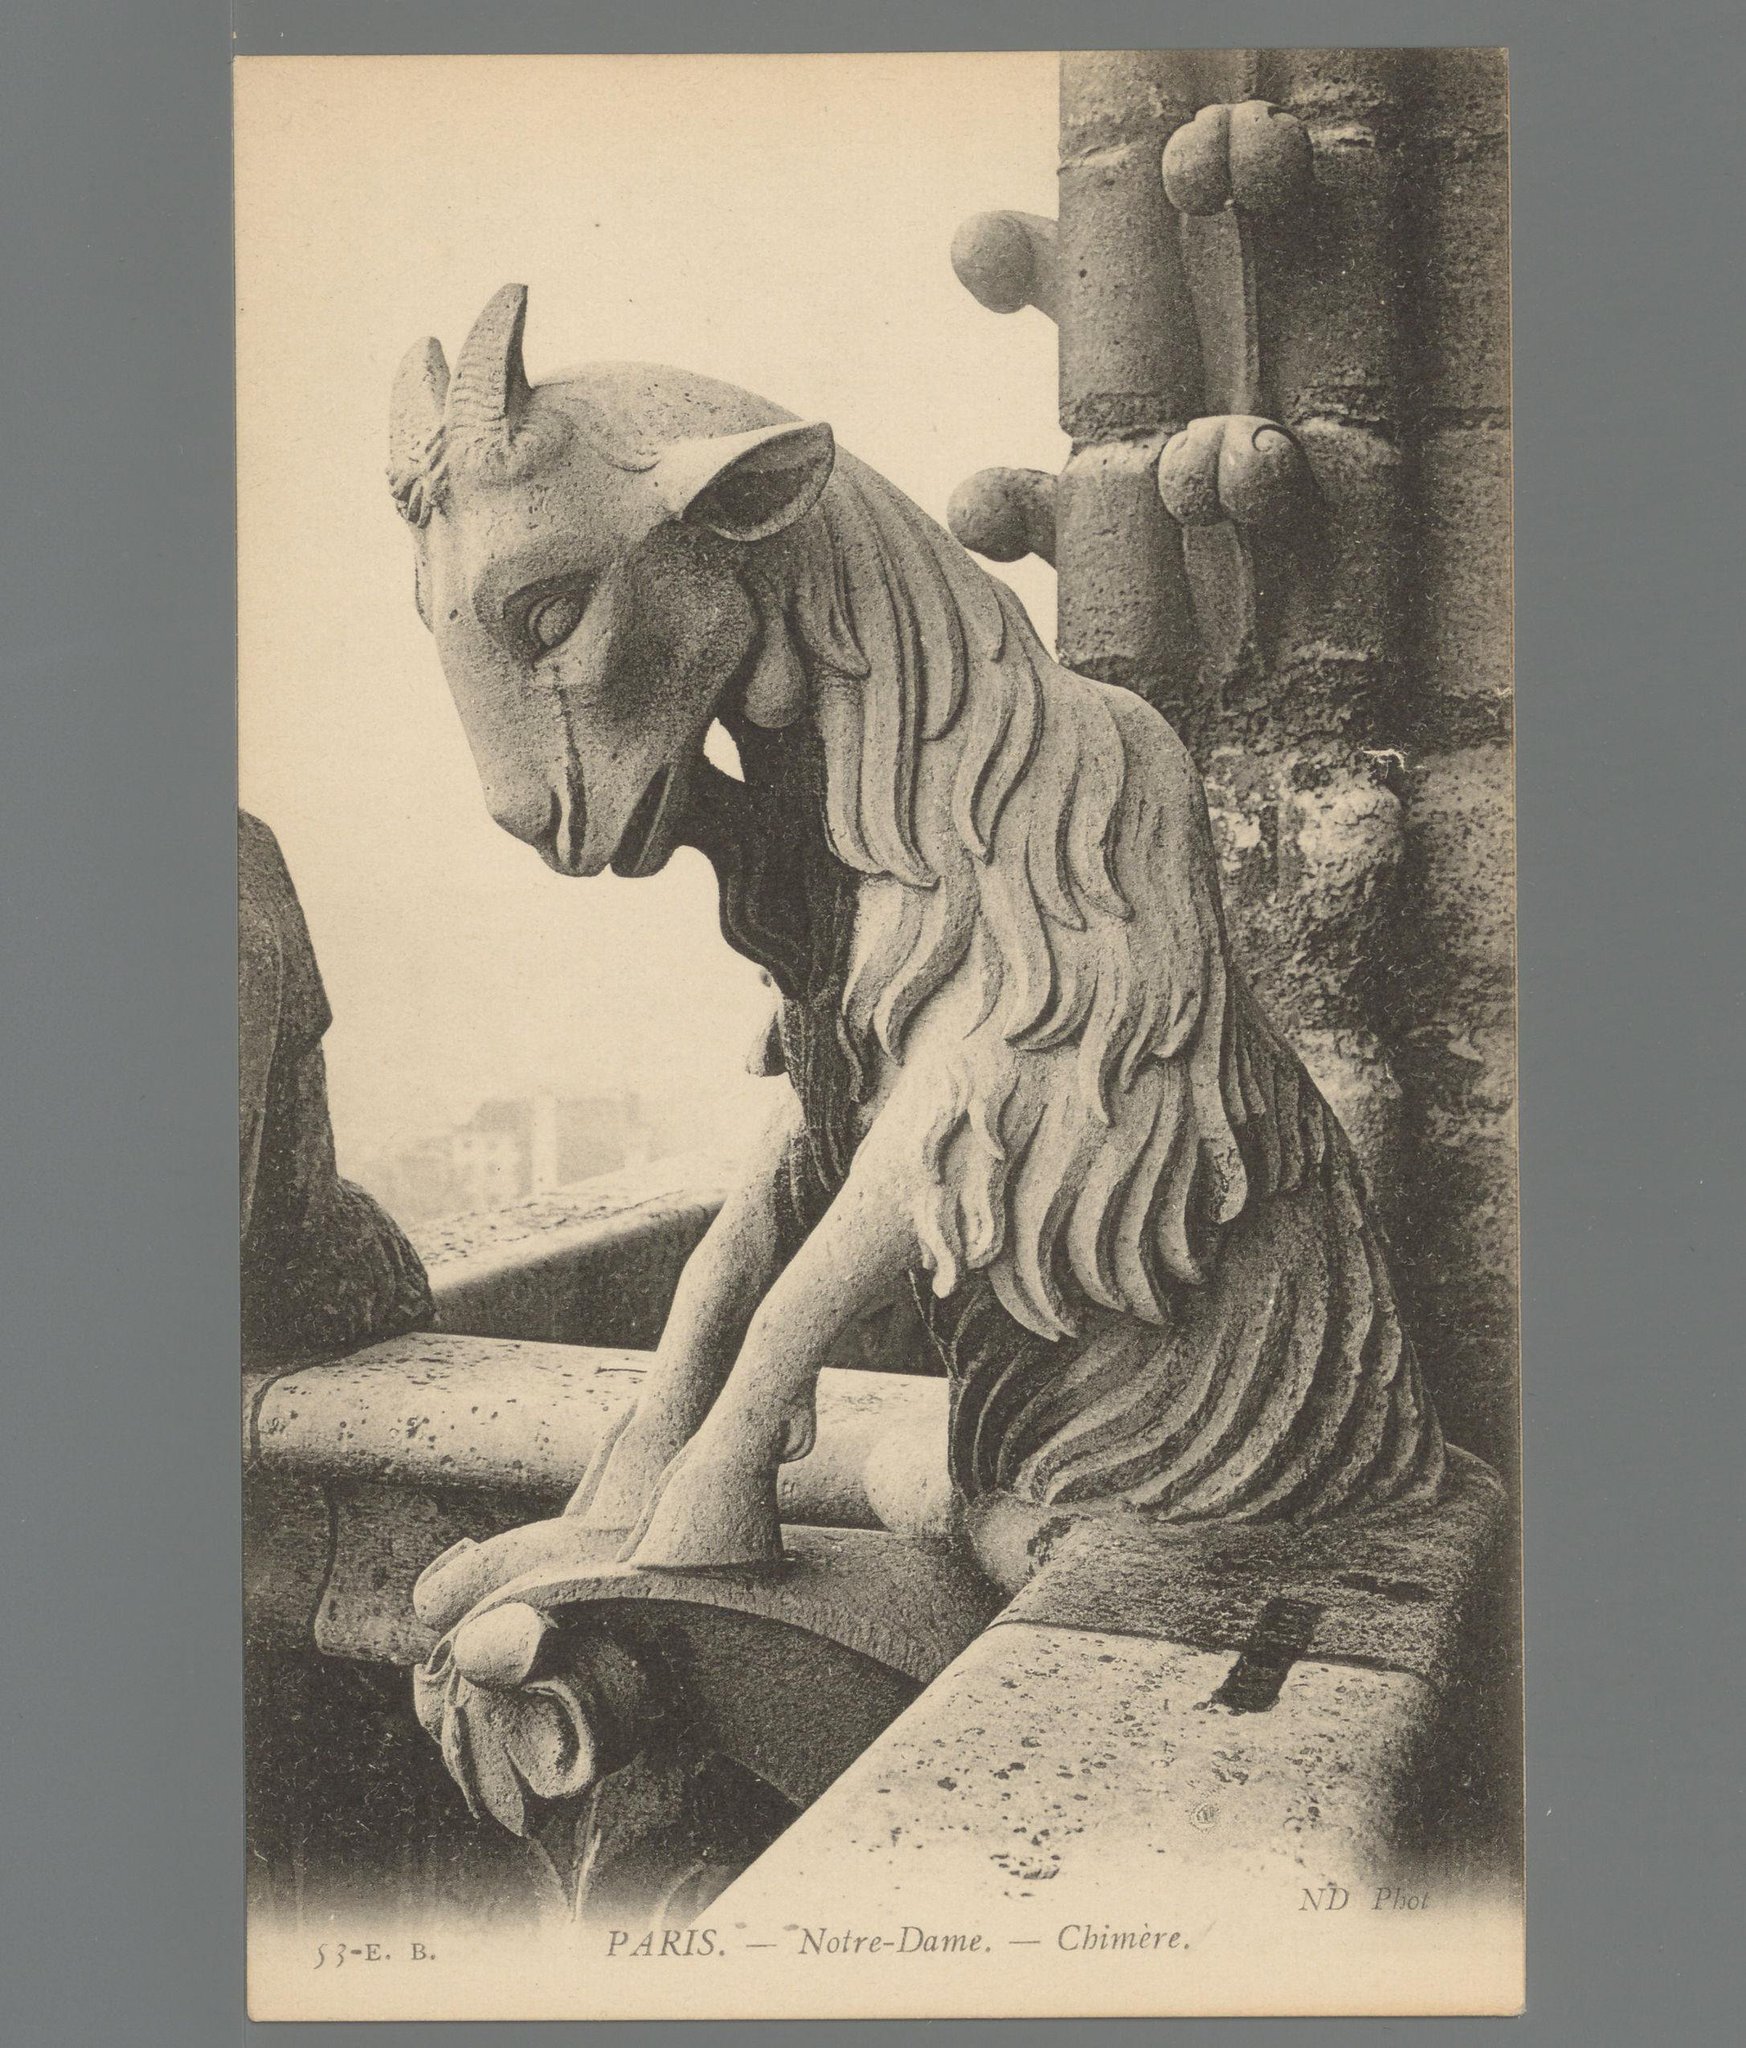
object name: photomechanical print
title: Paris. Notre-Dame. Chimère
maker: Anonymous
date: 1904-1906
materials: cardboard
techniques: photograph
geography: paris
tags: ornament ~ grotesque, church (exterior), chimera (lion/goat/snake); 'chimera' (ripa)